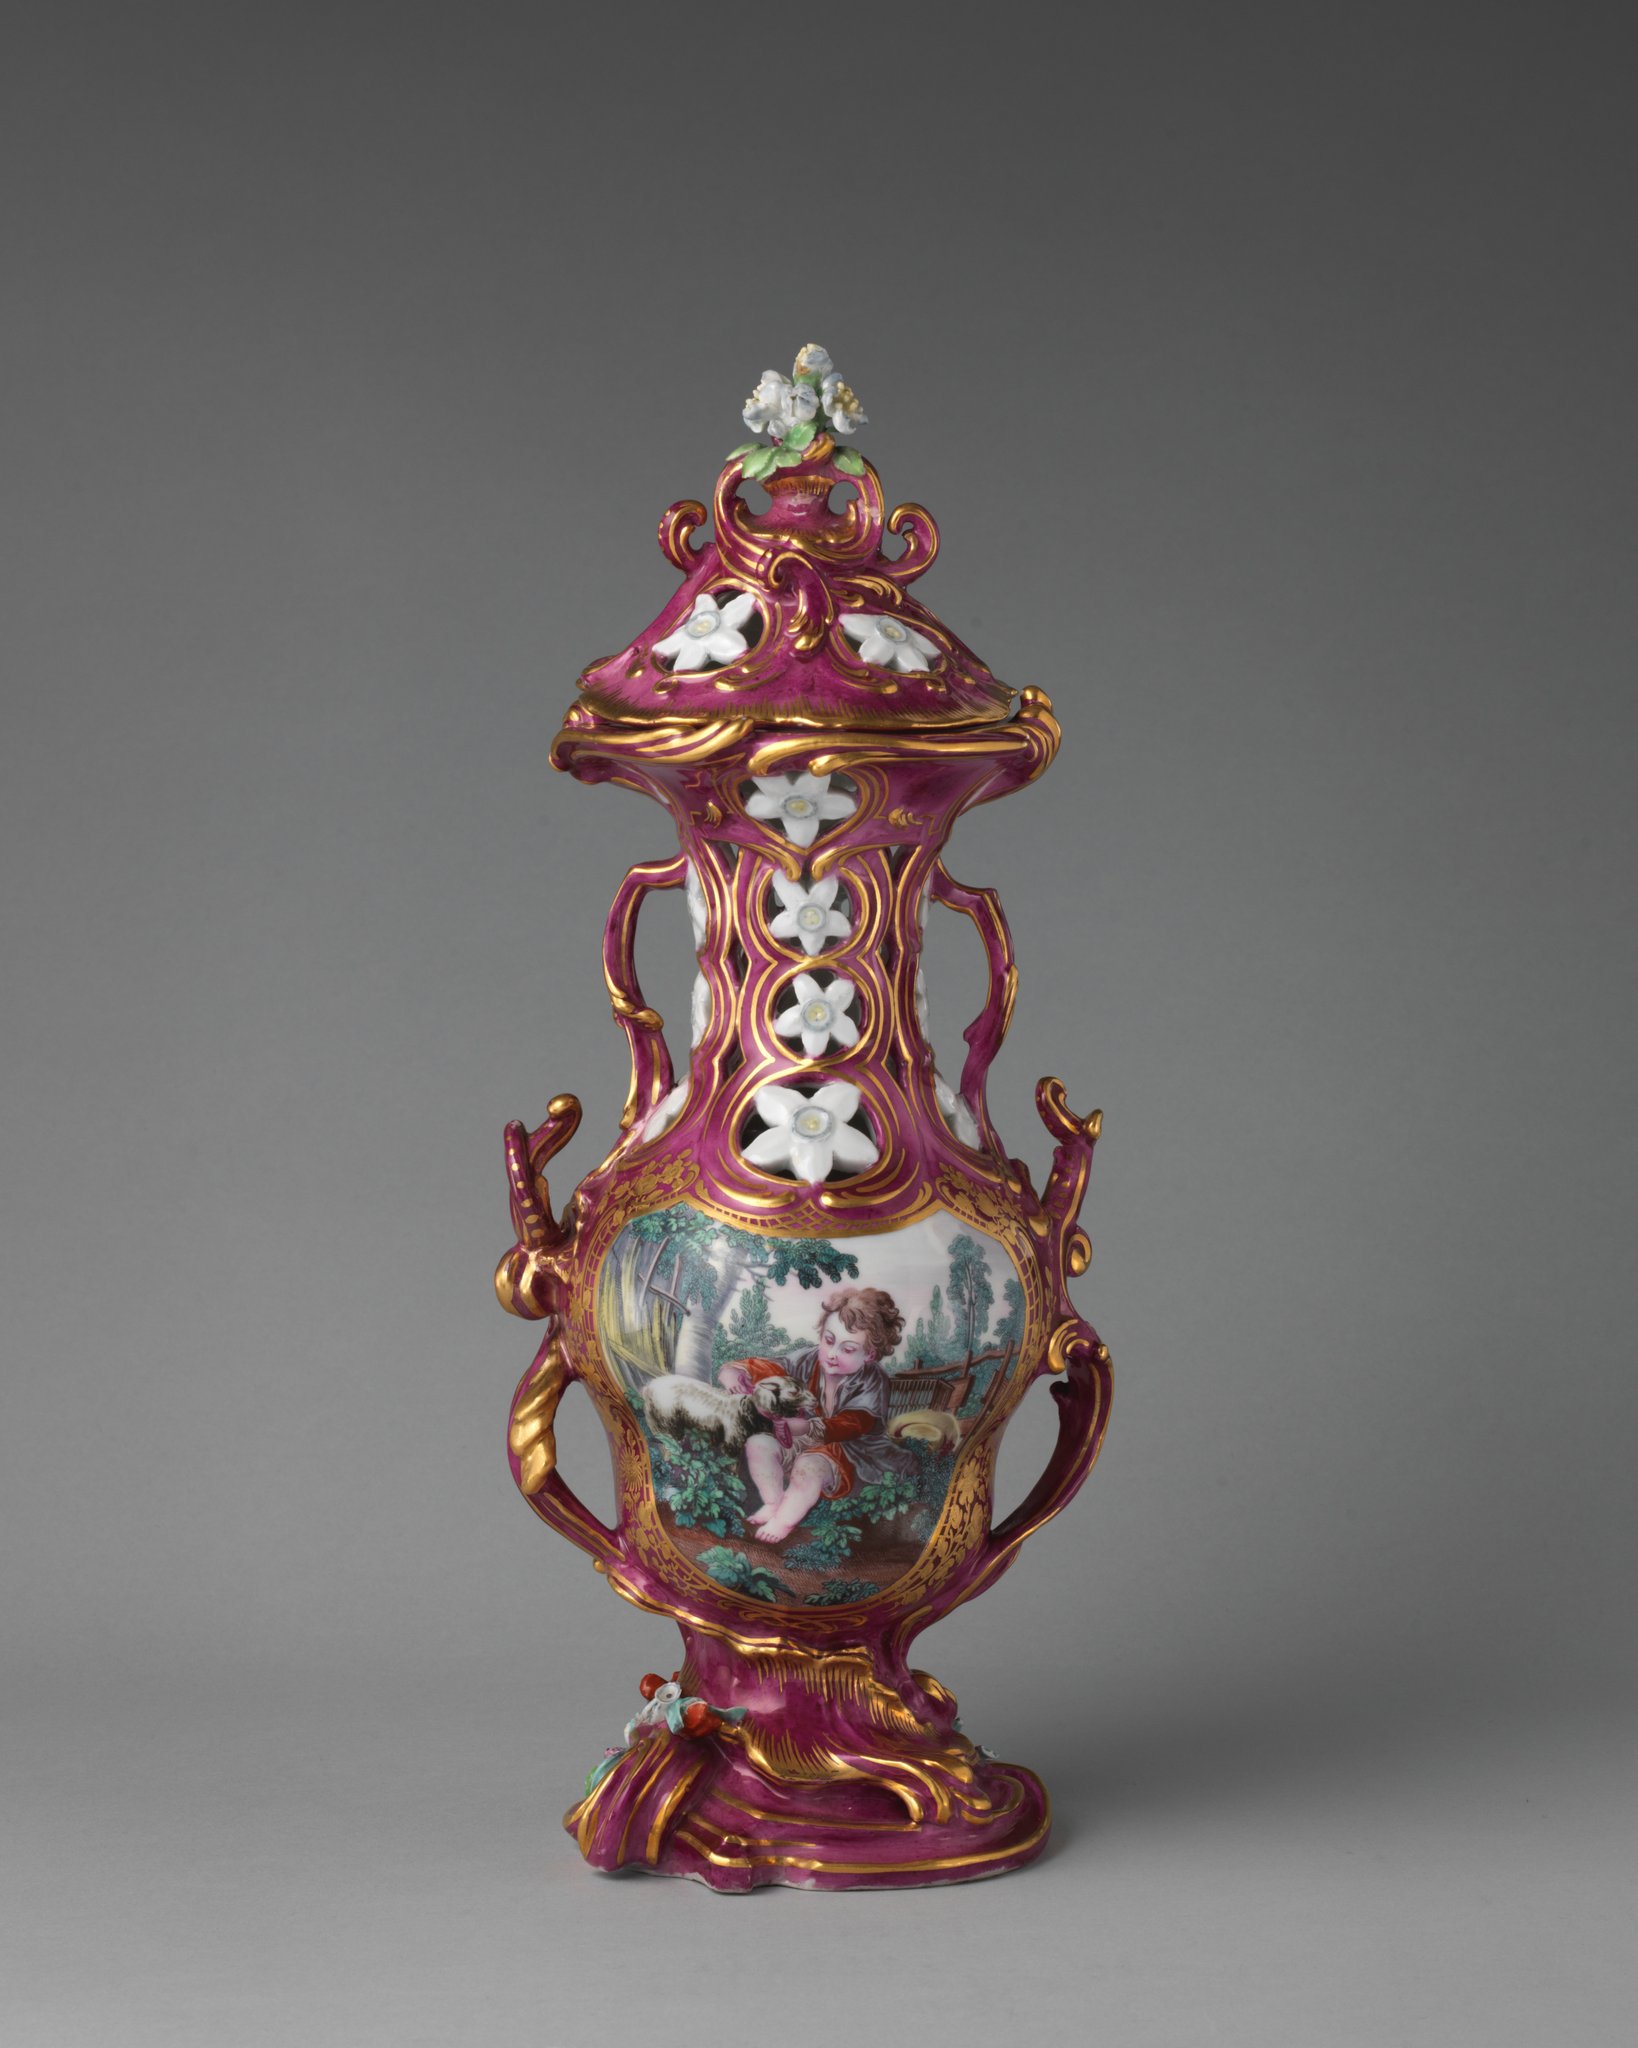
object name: vase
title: Vase (one of a set of three)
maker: chelsea porcelain manufactory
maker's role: factory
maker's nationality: british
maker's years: 1744-1784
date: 1761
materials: soft paste porcelain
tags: boys,goats,flowers